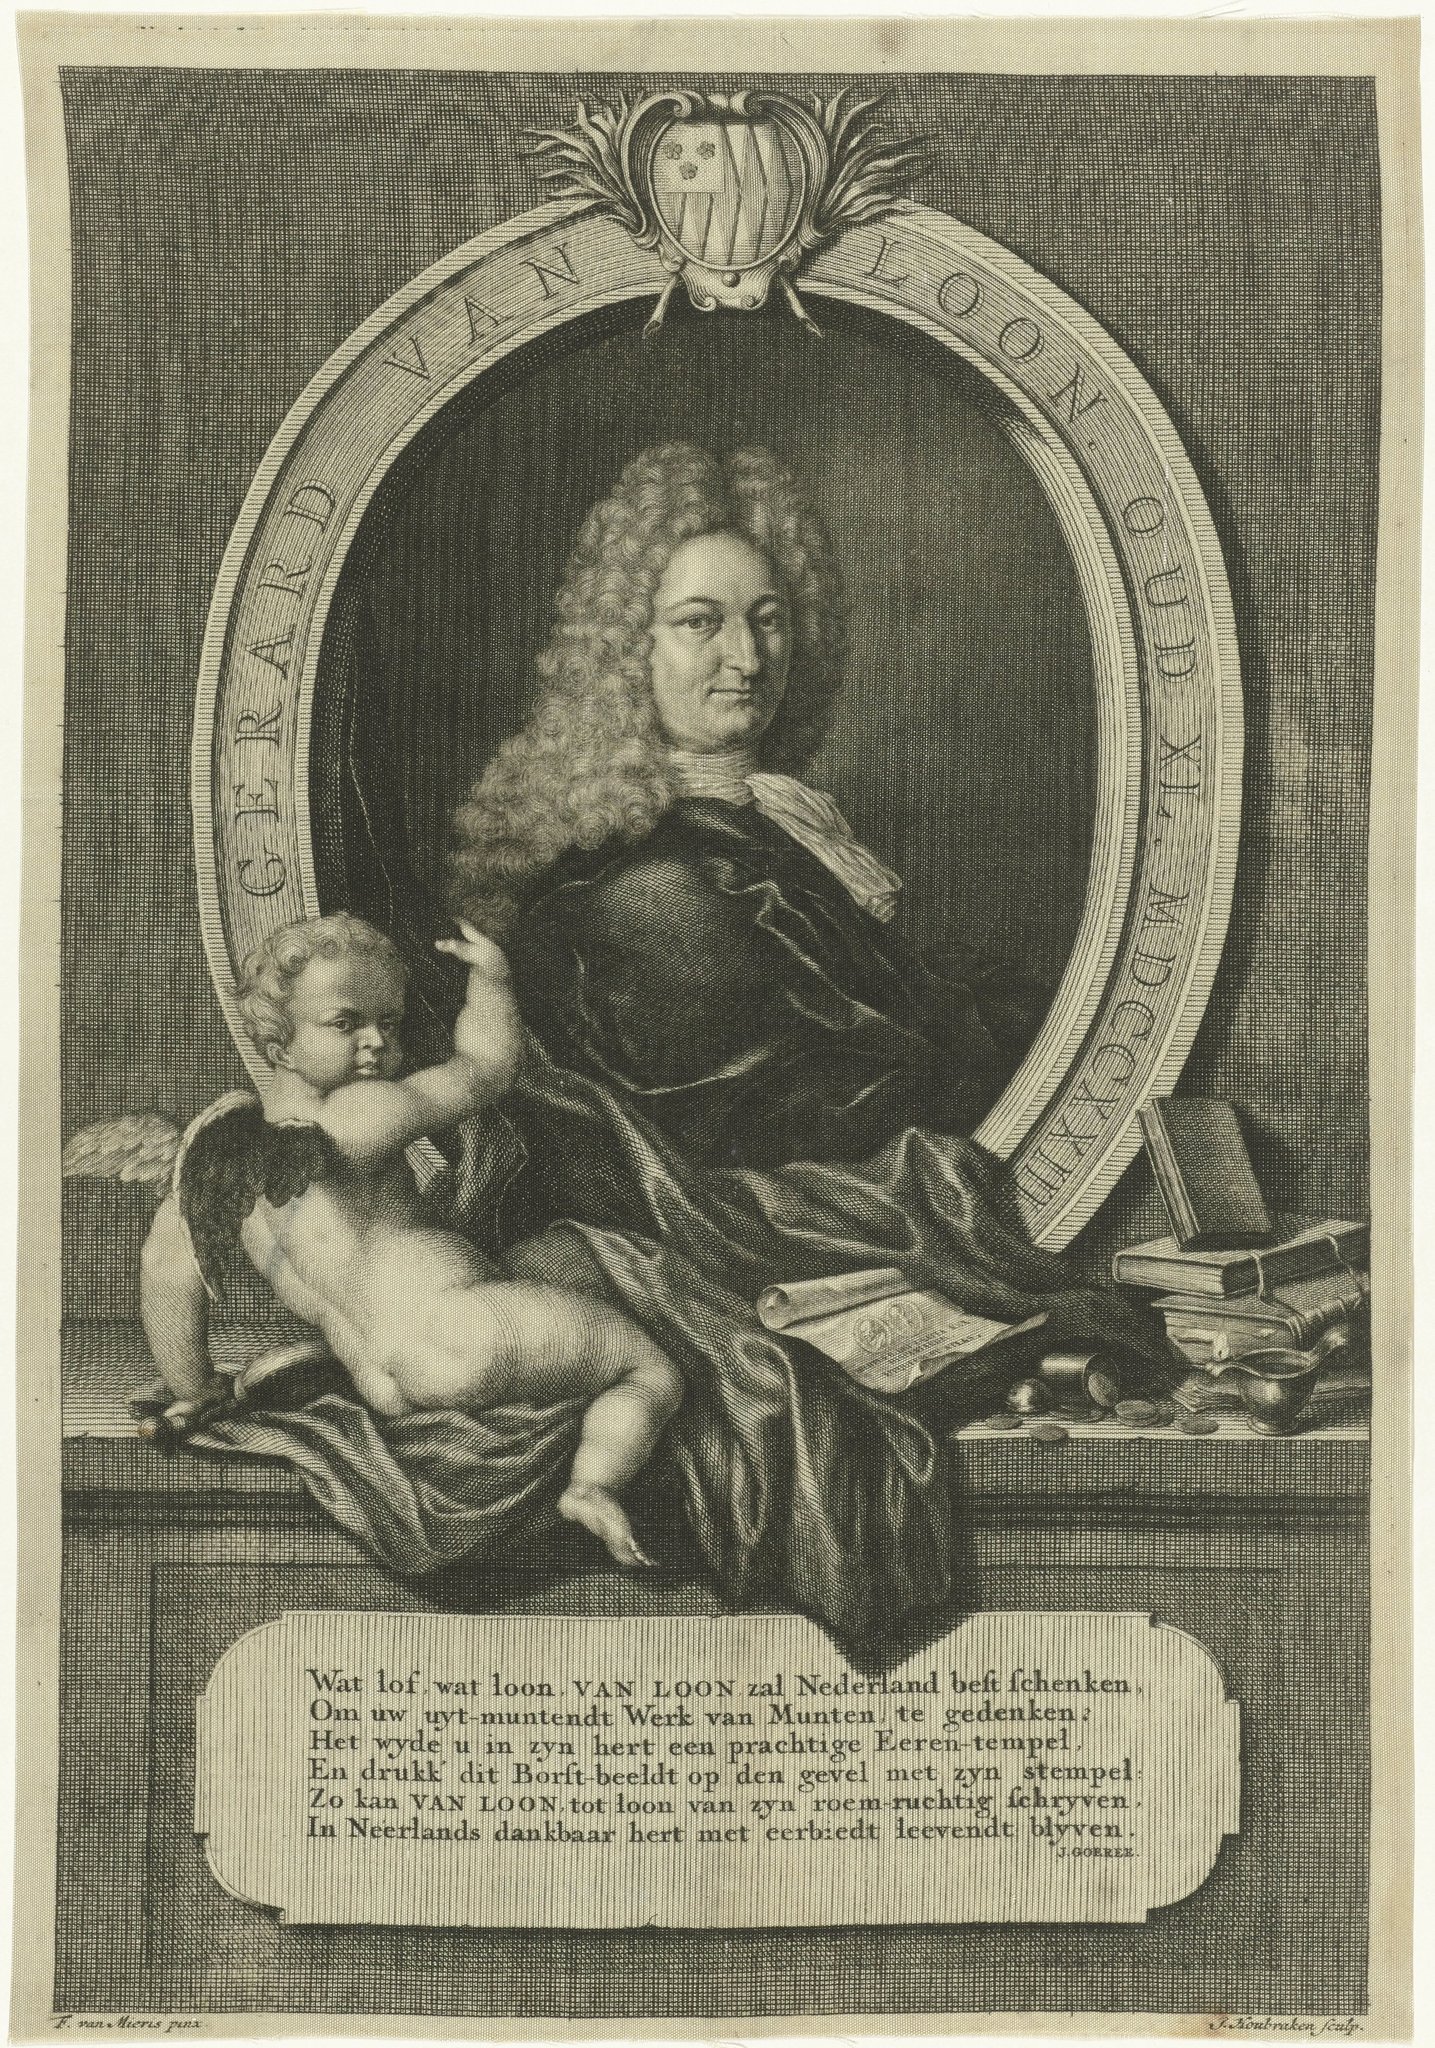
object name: print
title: Portret van Gerard van Loon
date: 1723-1732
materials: silk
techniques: engraving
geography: amsterdam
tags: designer, gerard van loon, cupids: 'amores', 'amoretti', 'putti'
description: Buste naar rechts van Gerard van Loon op 40-jarige leeftijd in een ovaal met randschrift en met bovenaan een wapen. Het portret rust op een sokkel met daarop een cartouche met een zesregelig vers in het Nederlands. Links op de sokkel naast het portret een putto die een stuk gordijn openhoudt en rechts boeken, een olielampje en munten.